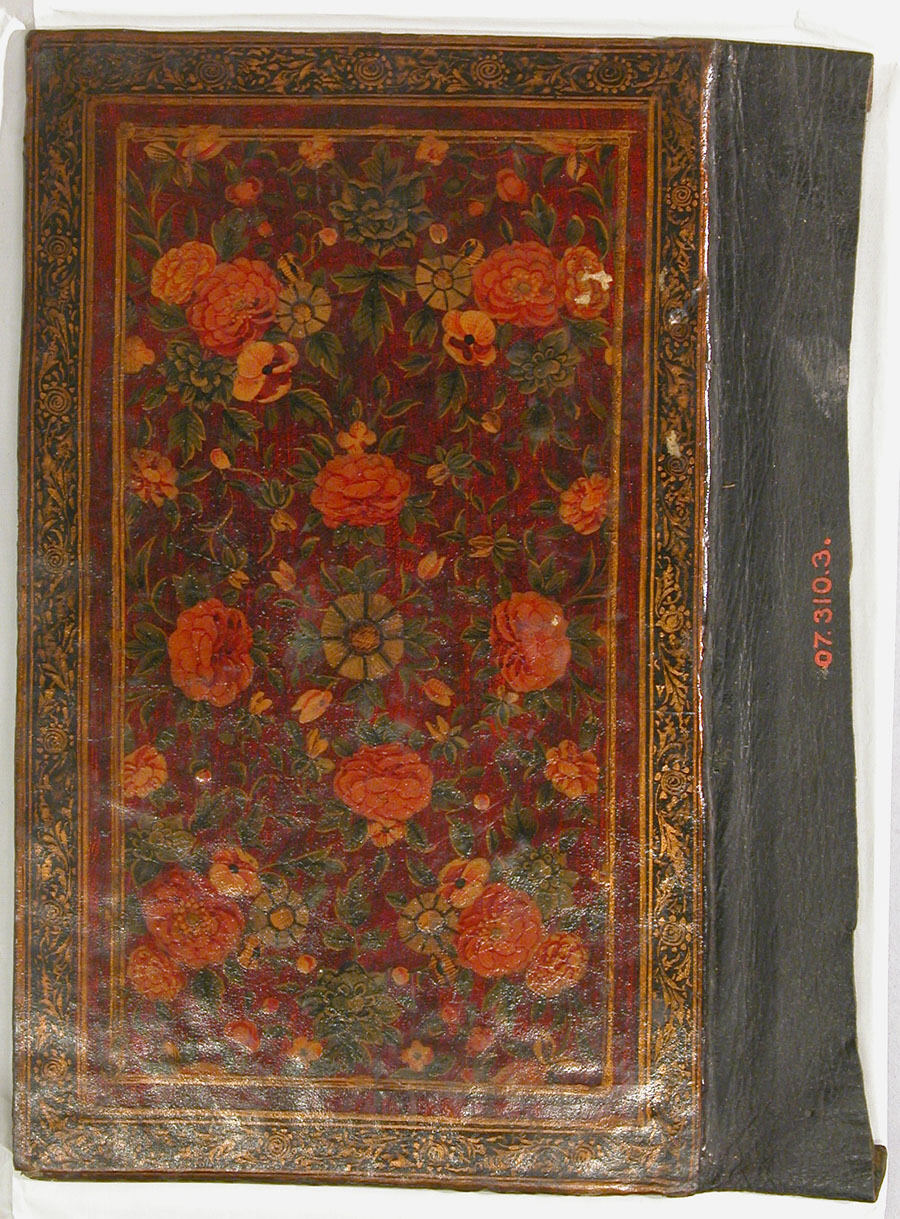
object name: bookbinding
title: Bookbinding (Jild-i kitab)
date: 1801-1900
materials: board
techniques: lacquer, painting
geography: iran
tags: flowers